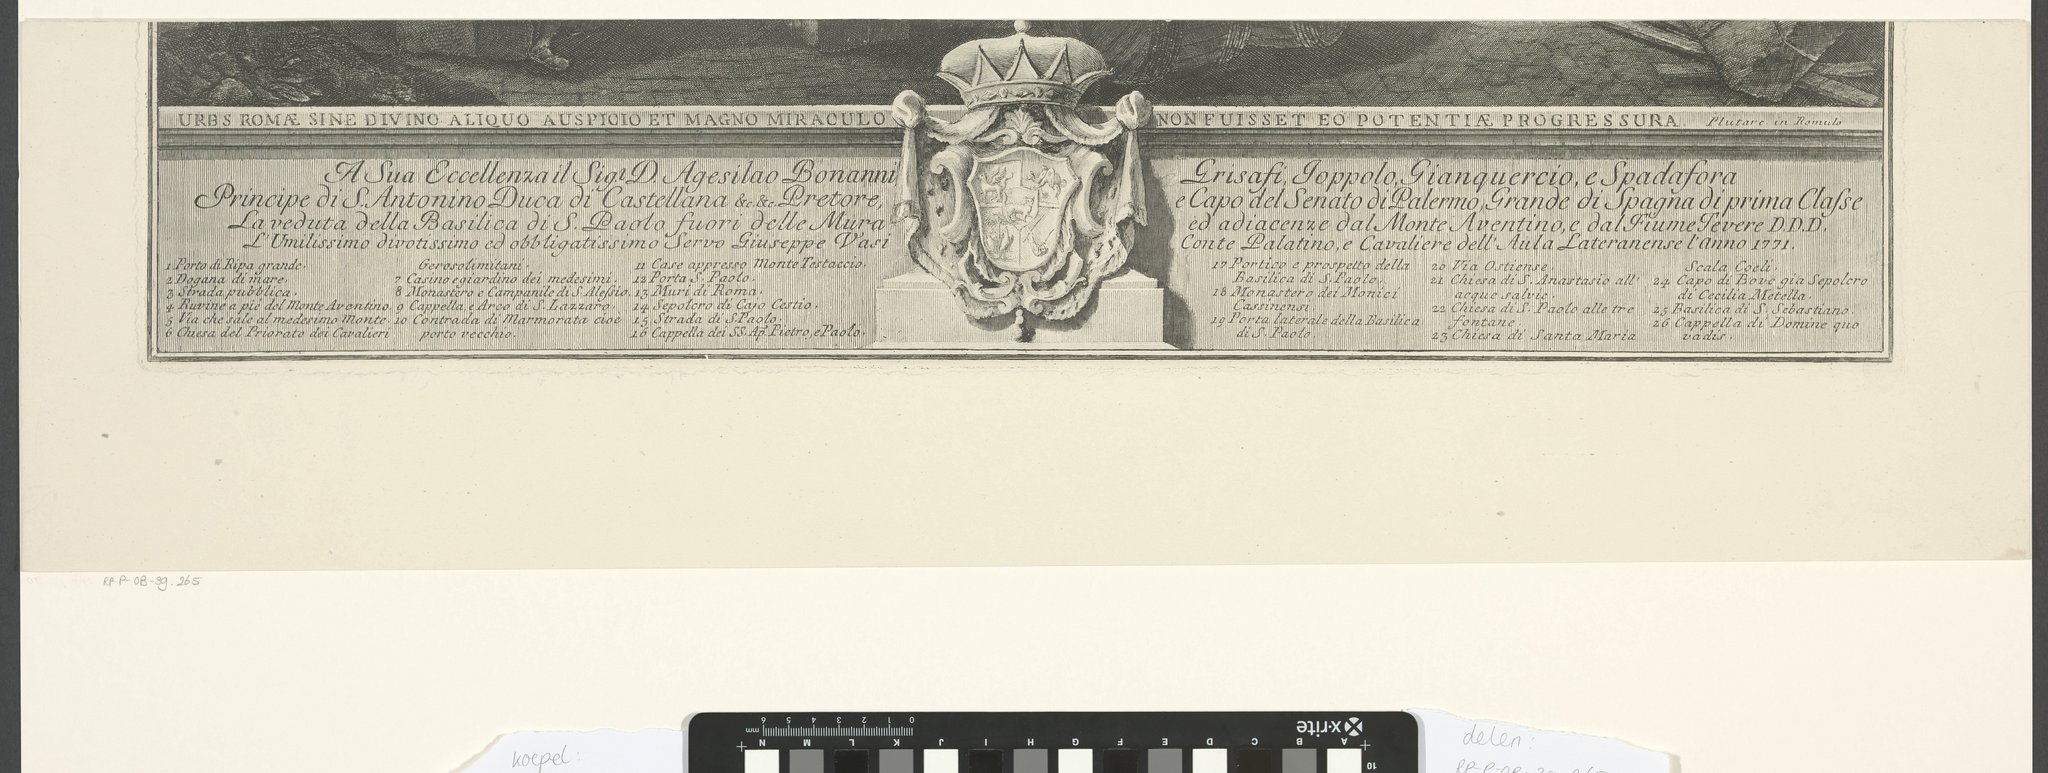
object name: print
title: Gezicht op de Tiber en Aventijn heuvel te Rome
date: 1771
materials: paper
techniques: etching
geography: rome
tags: city-view in general; 'veduta', rome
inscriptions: collector's mark: Lugt 2228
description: Deel van een gezicht op de Tiber en Aventijn heuvel te Rome. Verklarende lijst met nummers en wapenschild in ondermarge.